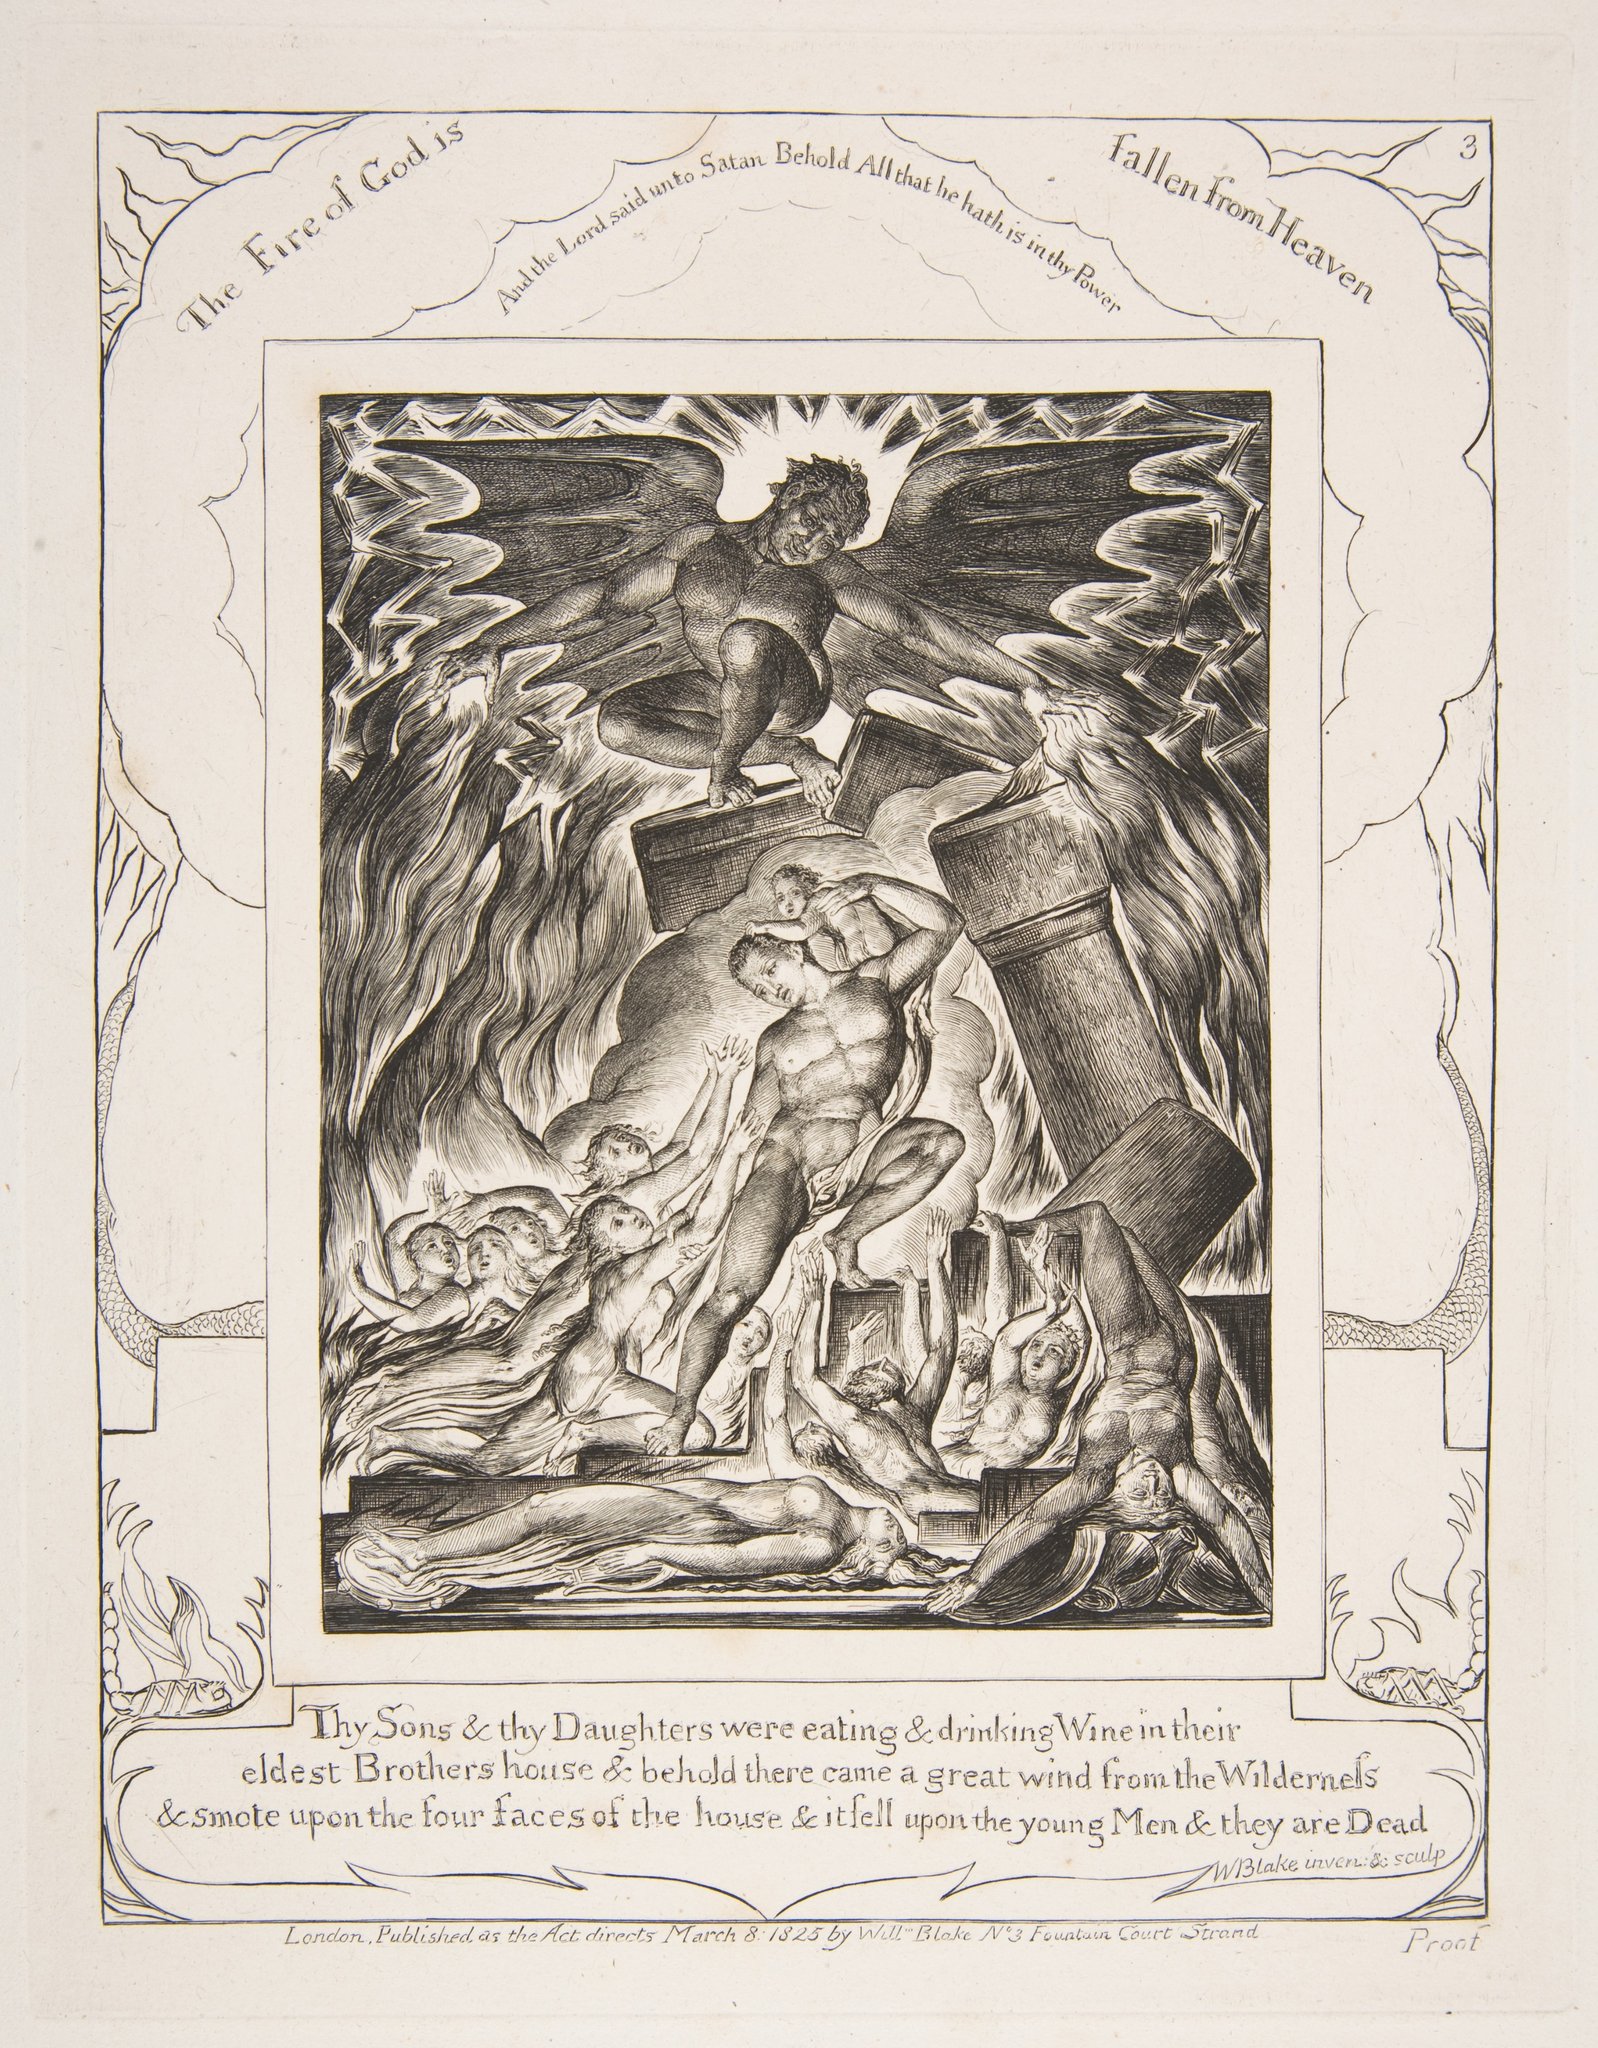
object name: print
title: The Destruction of Job's Sons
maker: william blake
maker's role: artist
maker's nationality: british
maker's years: 1757-1827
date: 1825-1826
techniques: engraving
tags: male nudes,female nudes,job